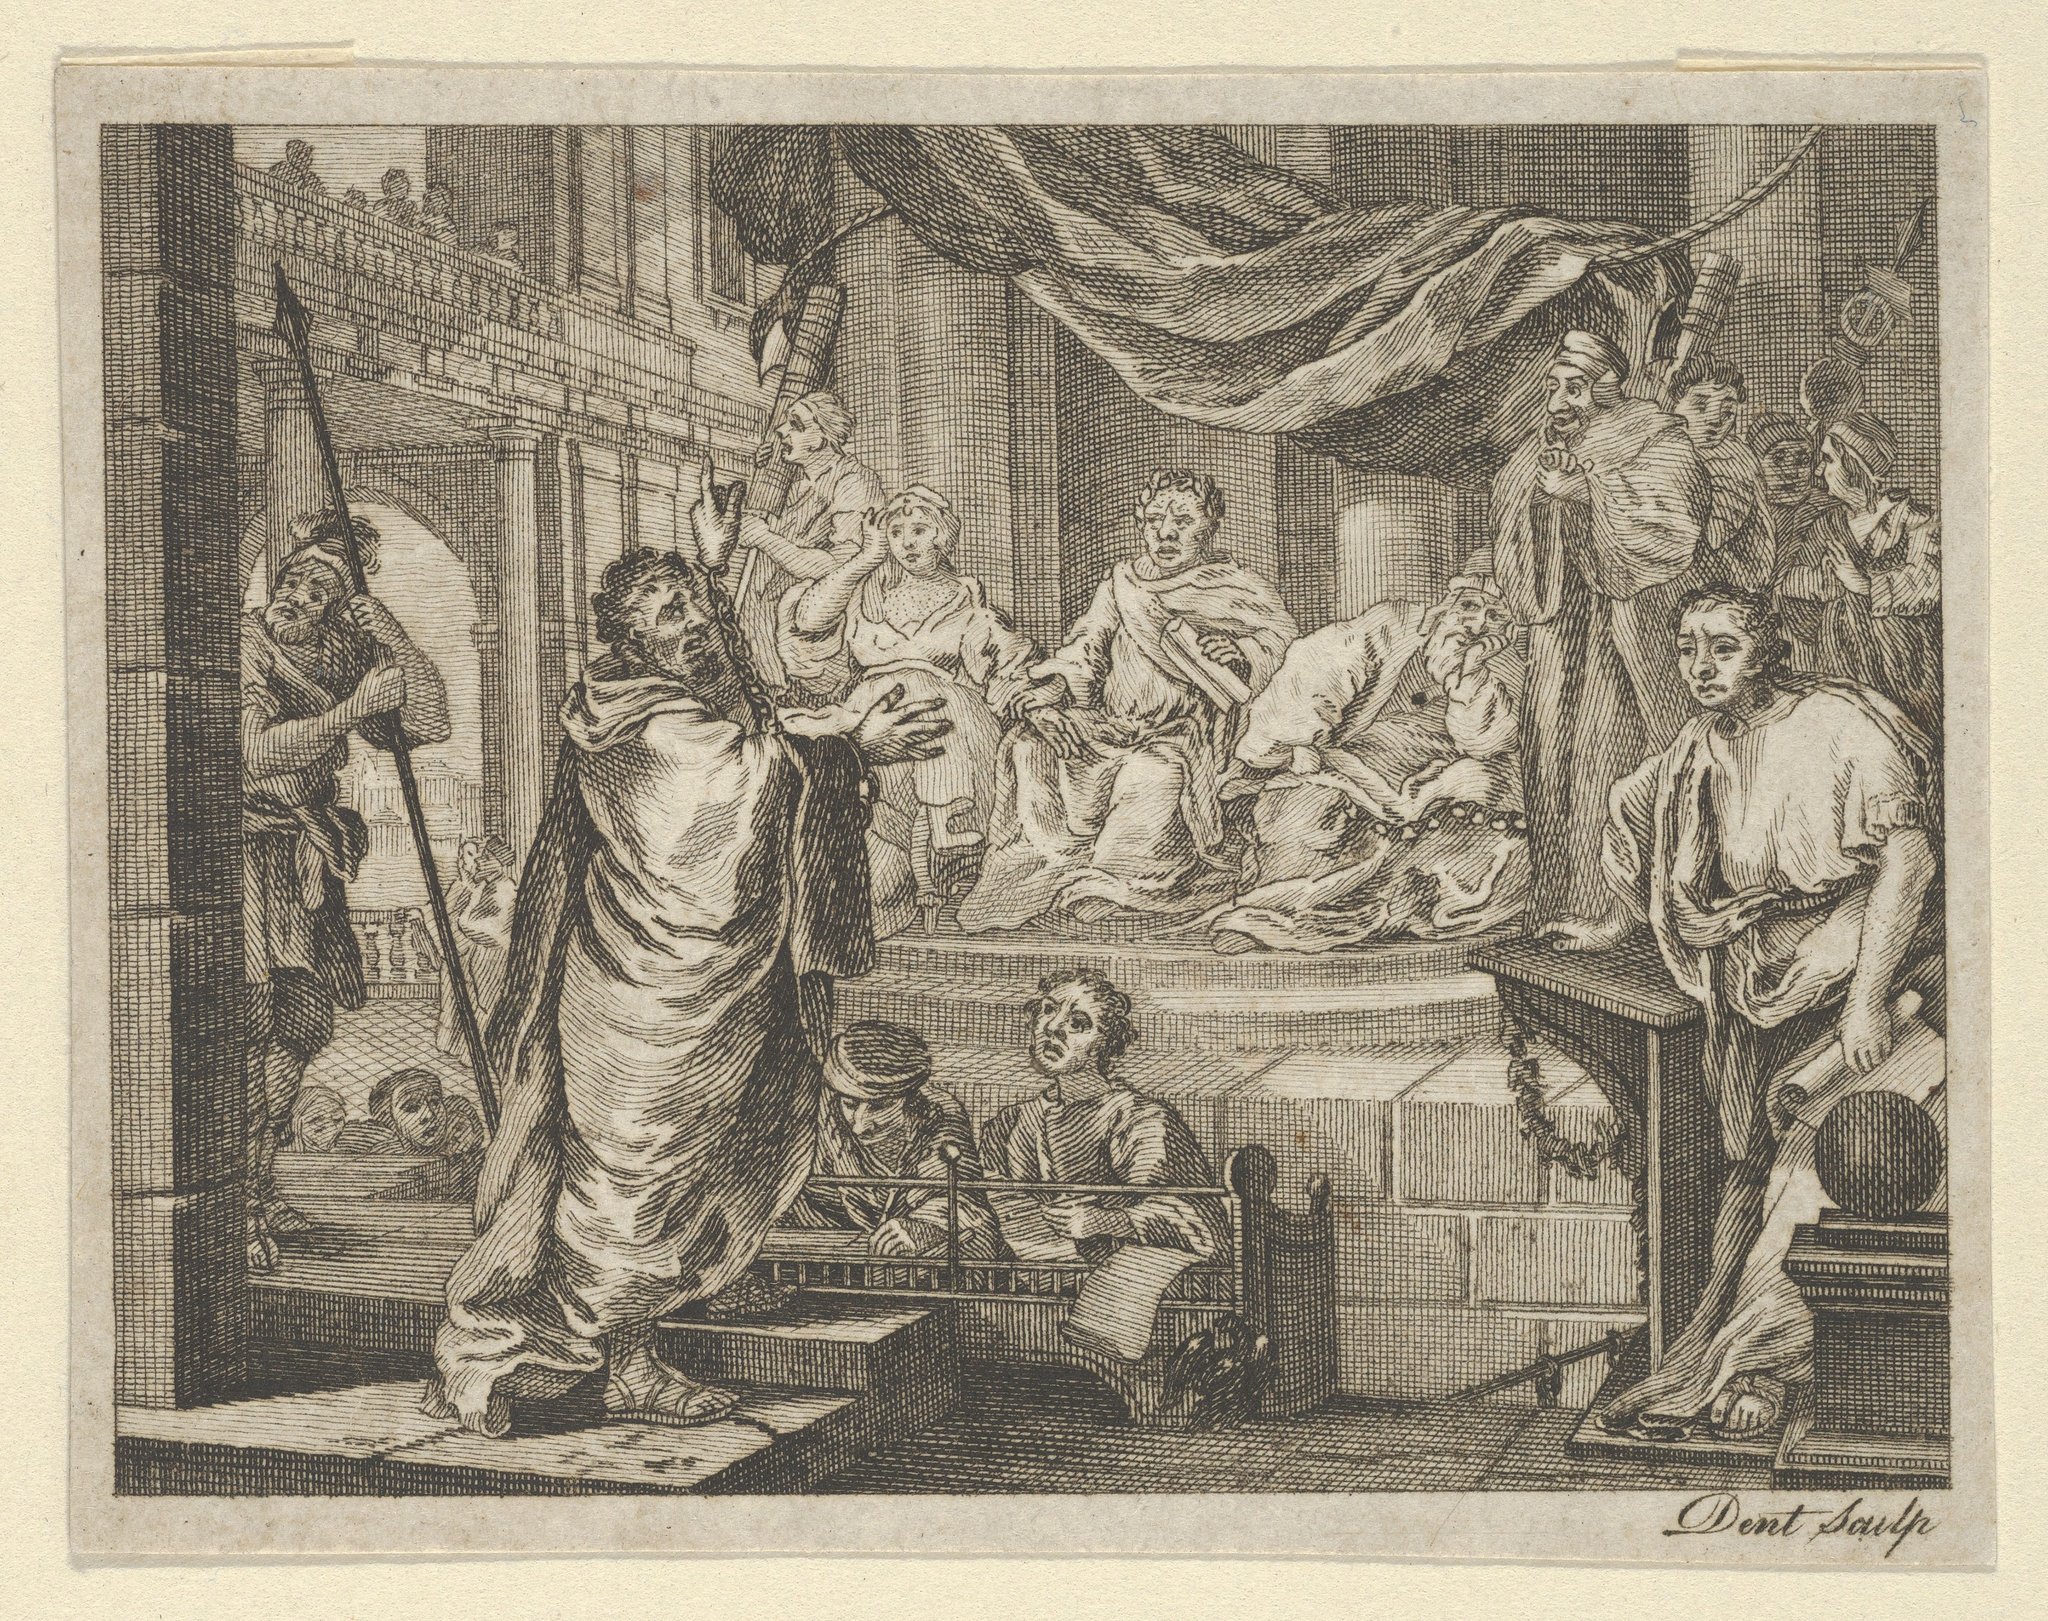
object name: print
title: Paul Before Felix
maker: dent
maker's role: engraver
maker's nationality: british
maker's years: 1800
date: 1800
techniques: engraving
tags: men,saint paul